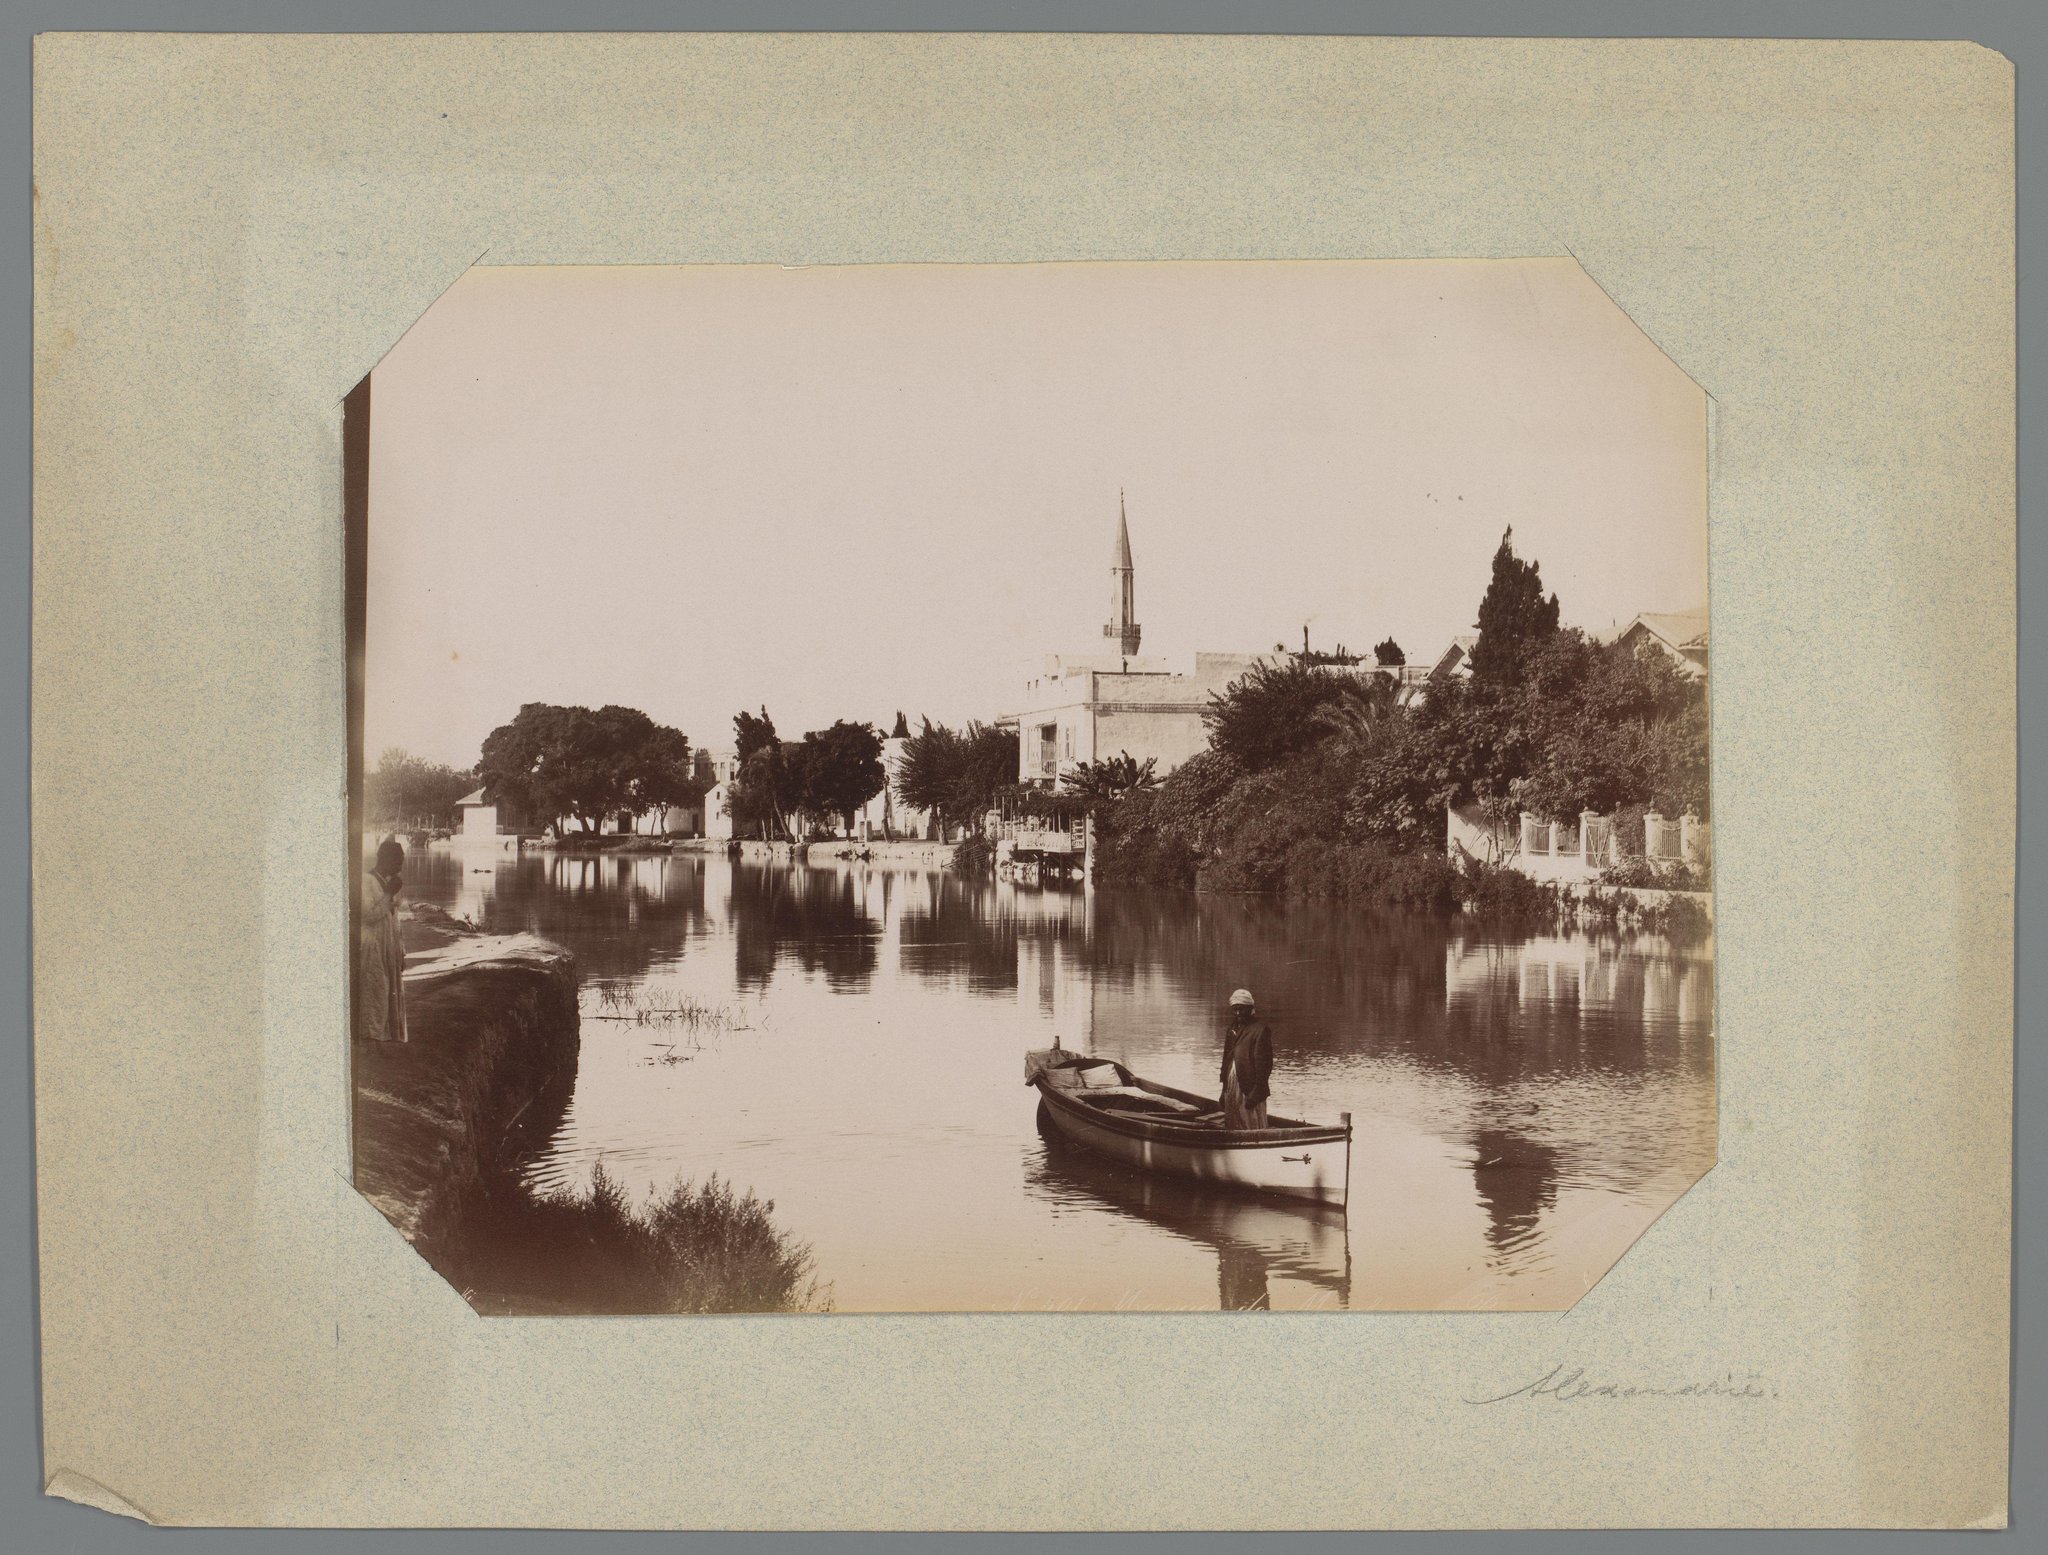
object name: photograph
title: Riviergezicht bij een moskee in Alexandrië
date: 1870-1910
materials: cardboard, paper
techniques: albumen print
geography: alexandria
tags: temple, shrine ~ islam, mohammedanism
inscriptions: number: ‘No 501’